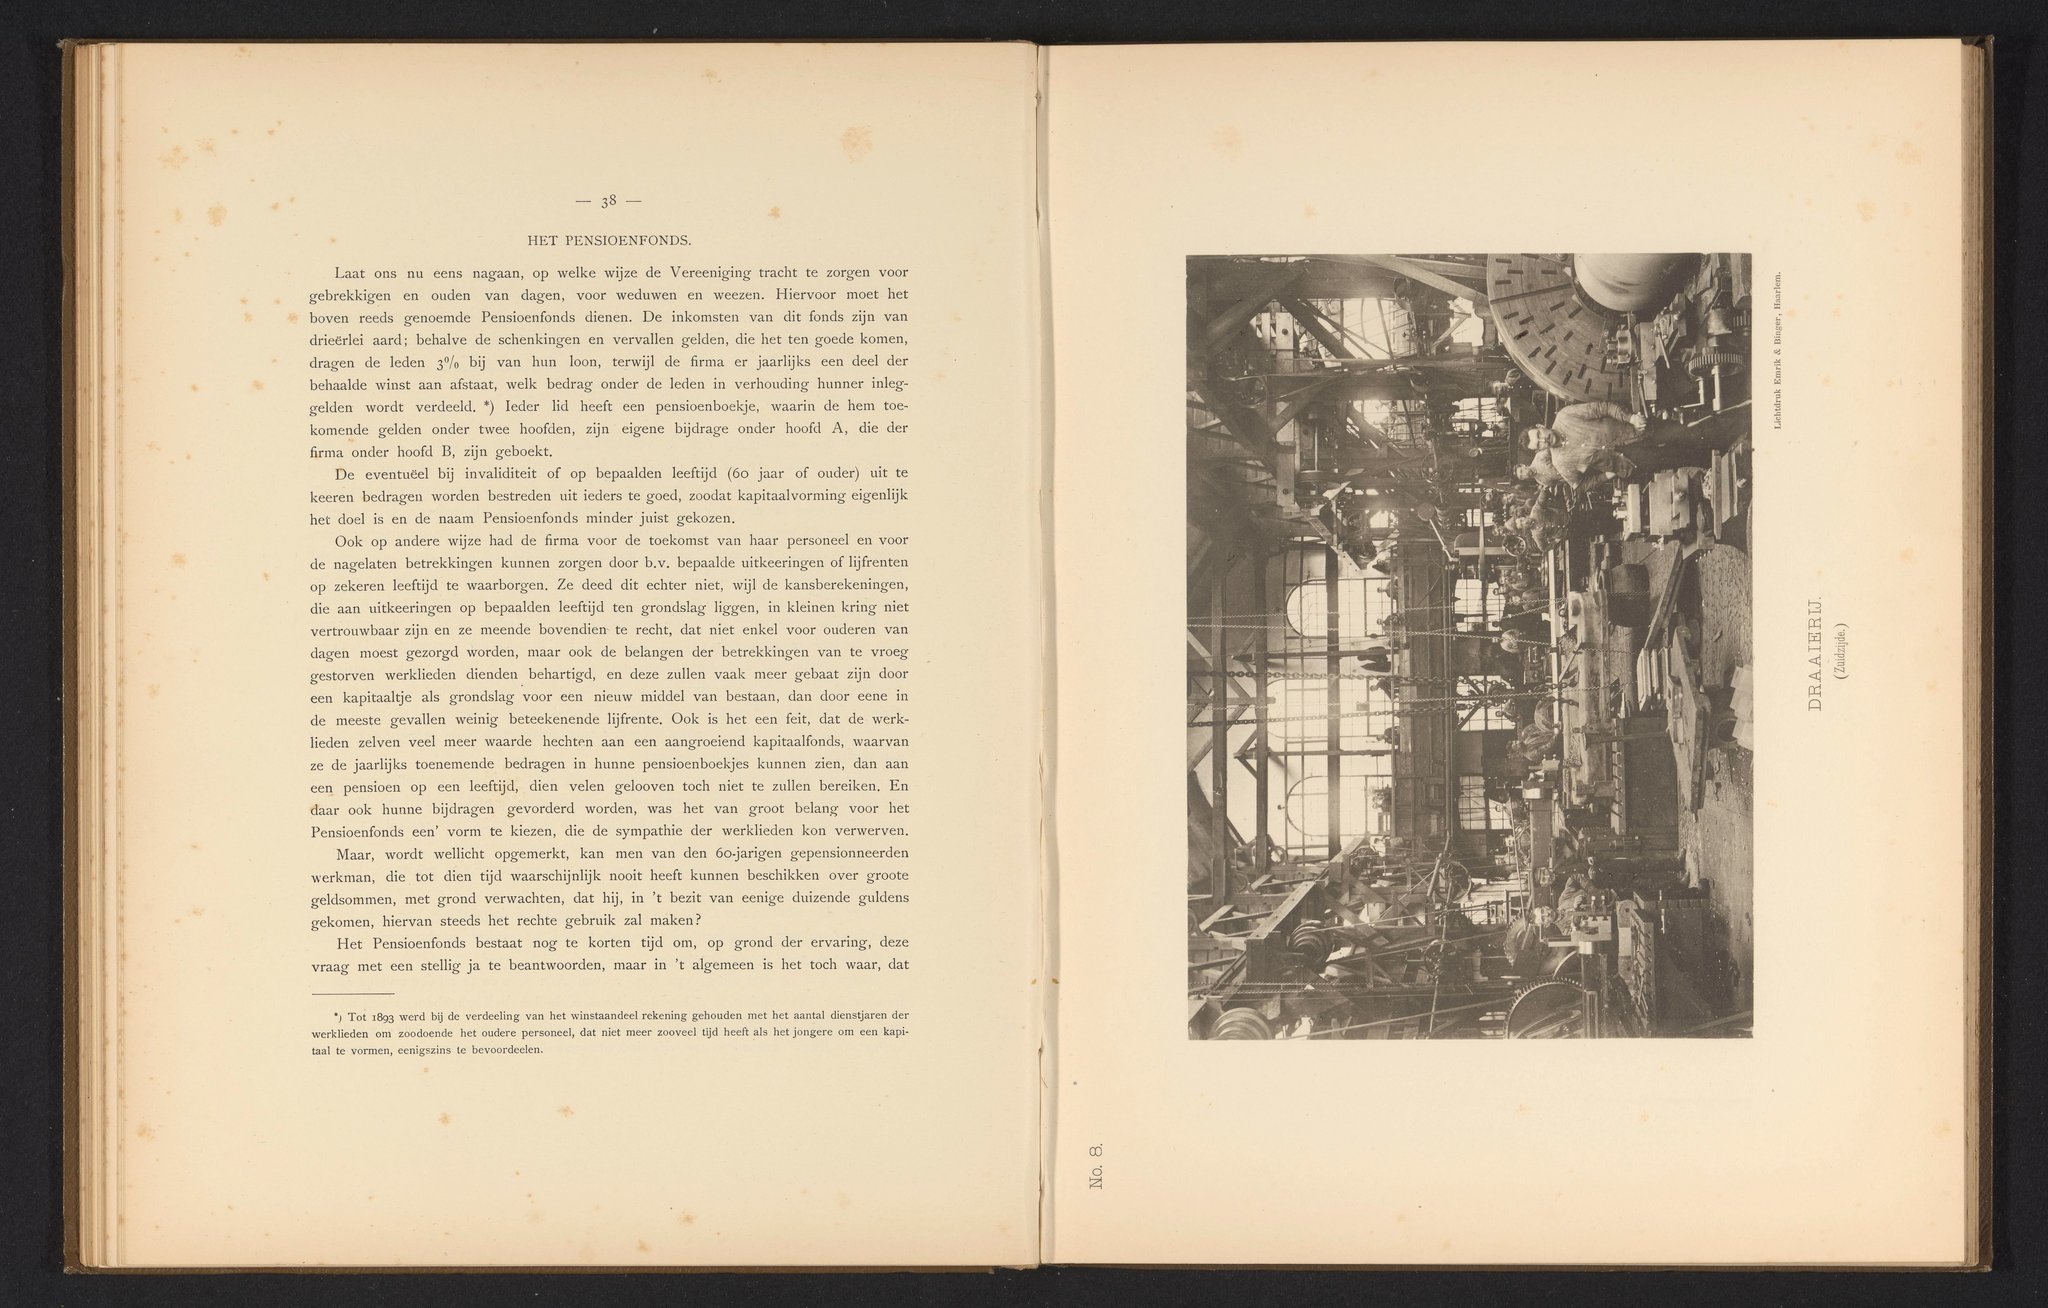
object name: photomechanical print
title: Draaierij. (Zuidzijde)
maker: Anonymous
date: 1884-1894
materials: paper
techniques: photograph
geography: haarlem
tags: factory-building, factory-interior, machine shop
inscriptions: number: ‘No. 8.’